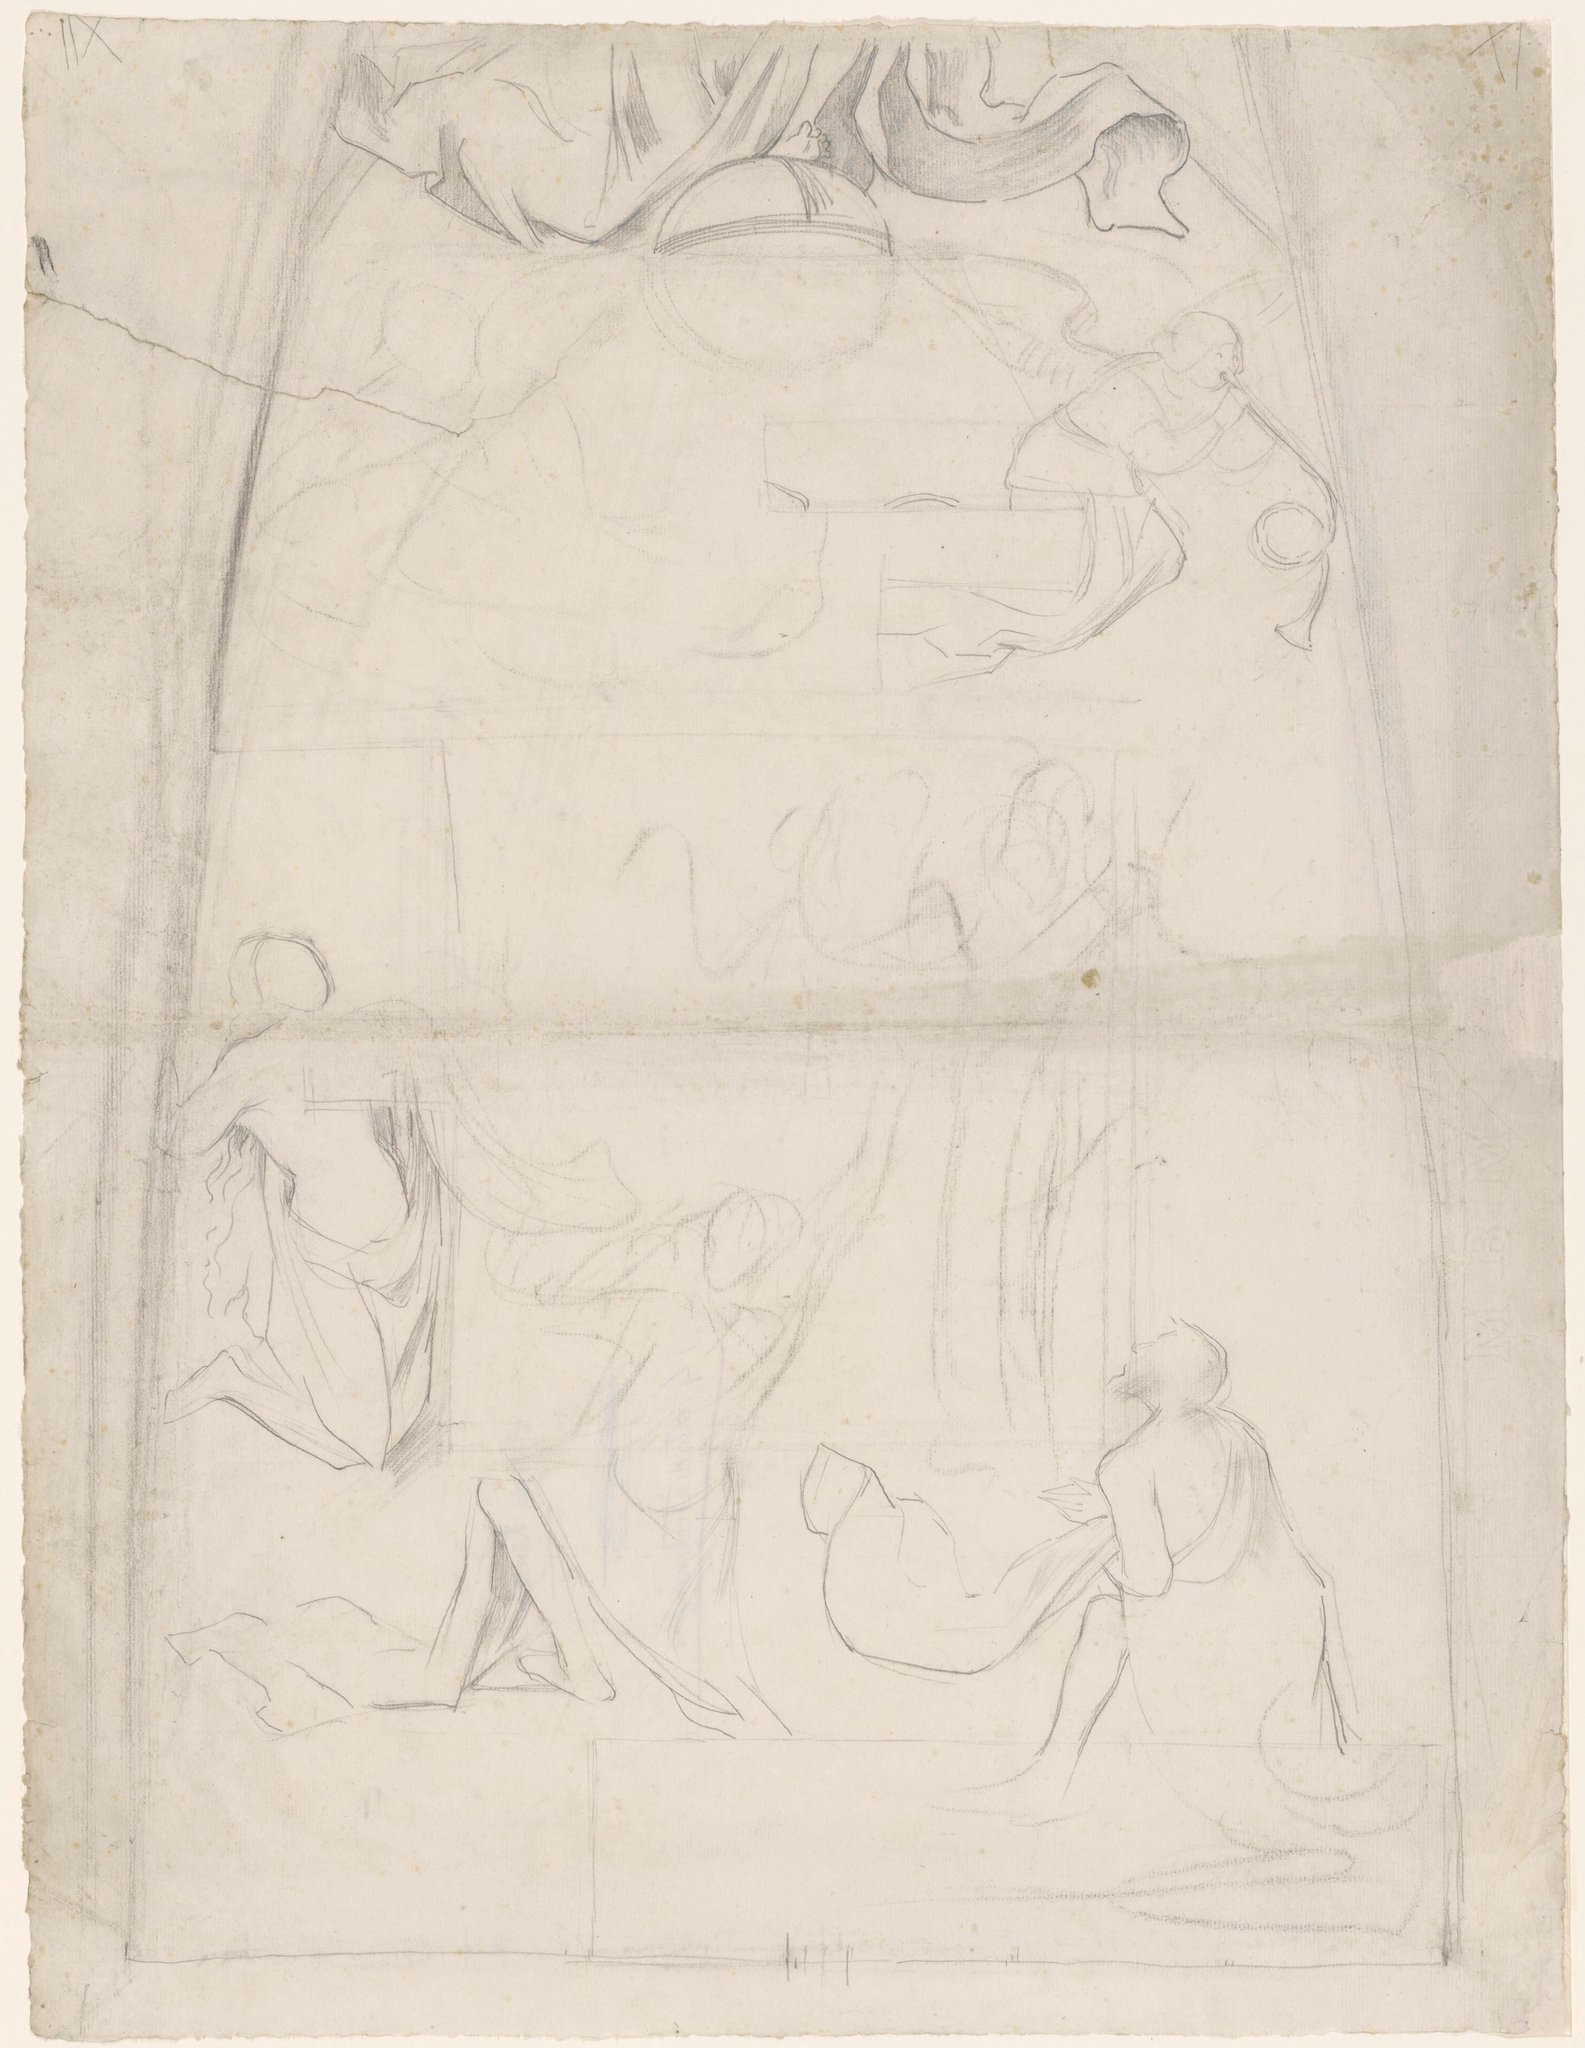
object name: drawing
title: Schetsblad met Hemelvaart van Christus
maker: antoon derkinderen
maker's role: draughtsman, painter, print maker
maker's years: 1859-1925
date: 1869-1925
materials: paper, pencil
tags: christ almost vanished: only feet visible ~ ascension